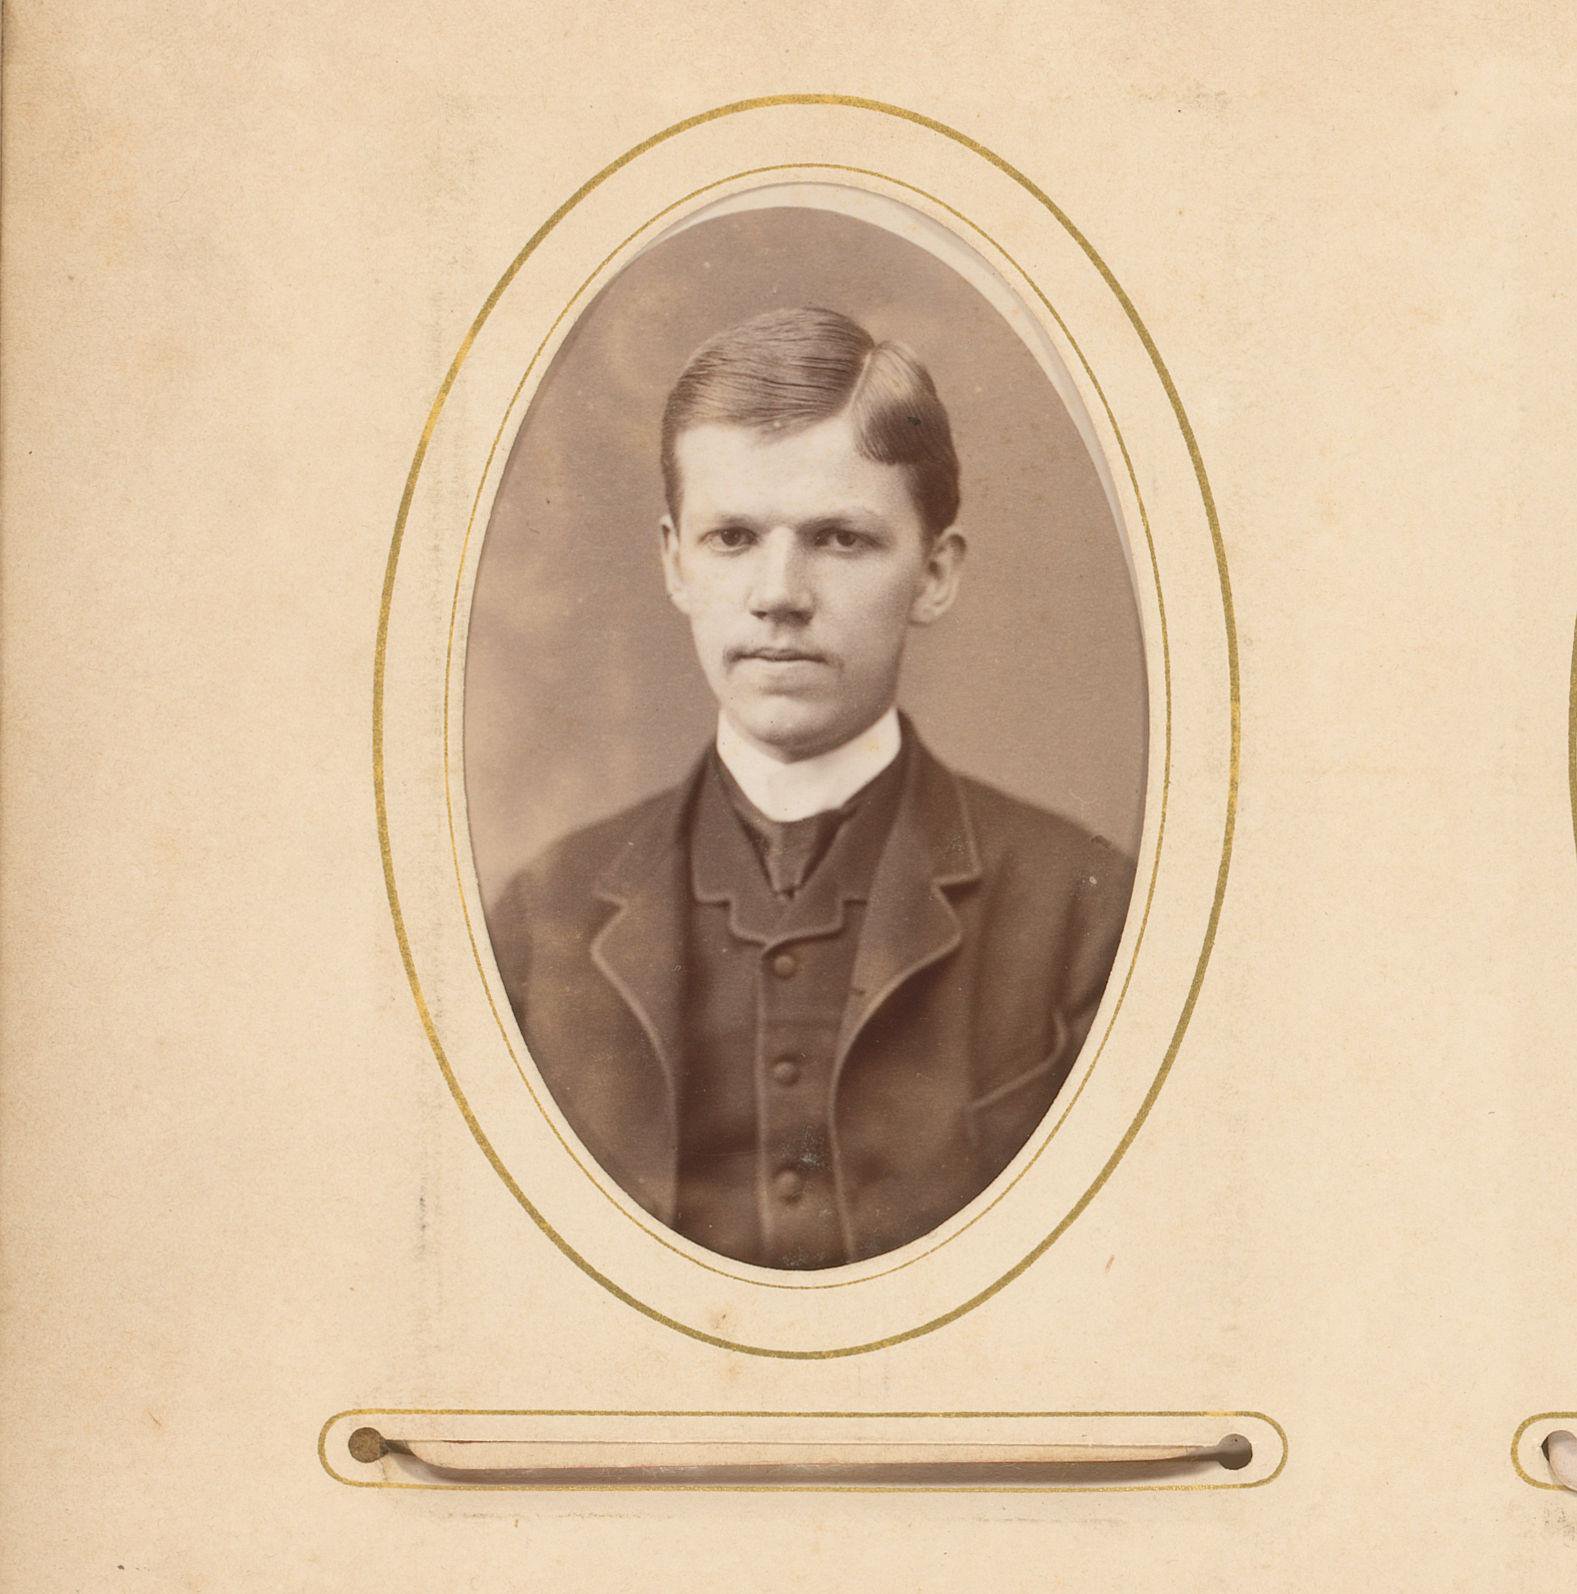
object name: photograph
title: Portret van een jongeman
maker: marcus guttenberg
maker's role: fotograaf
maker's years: 1828-1891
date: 1860-1900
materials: cardboard, photographic support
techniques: albumen print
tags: historical persons, youth, adolescent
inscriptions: inscription: ‘M. Guttenberg/ Patronized by Her Majesty/ Photographer/ (...)/ Kensington House/ 316, Oxford Road/ and/ (Central-Chambers)/ 26, Victoria Street/ Manchester (...)’